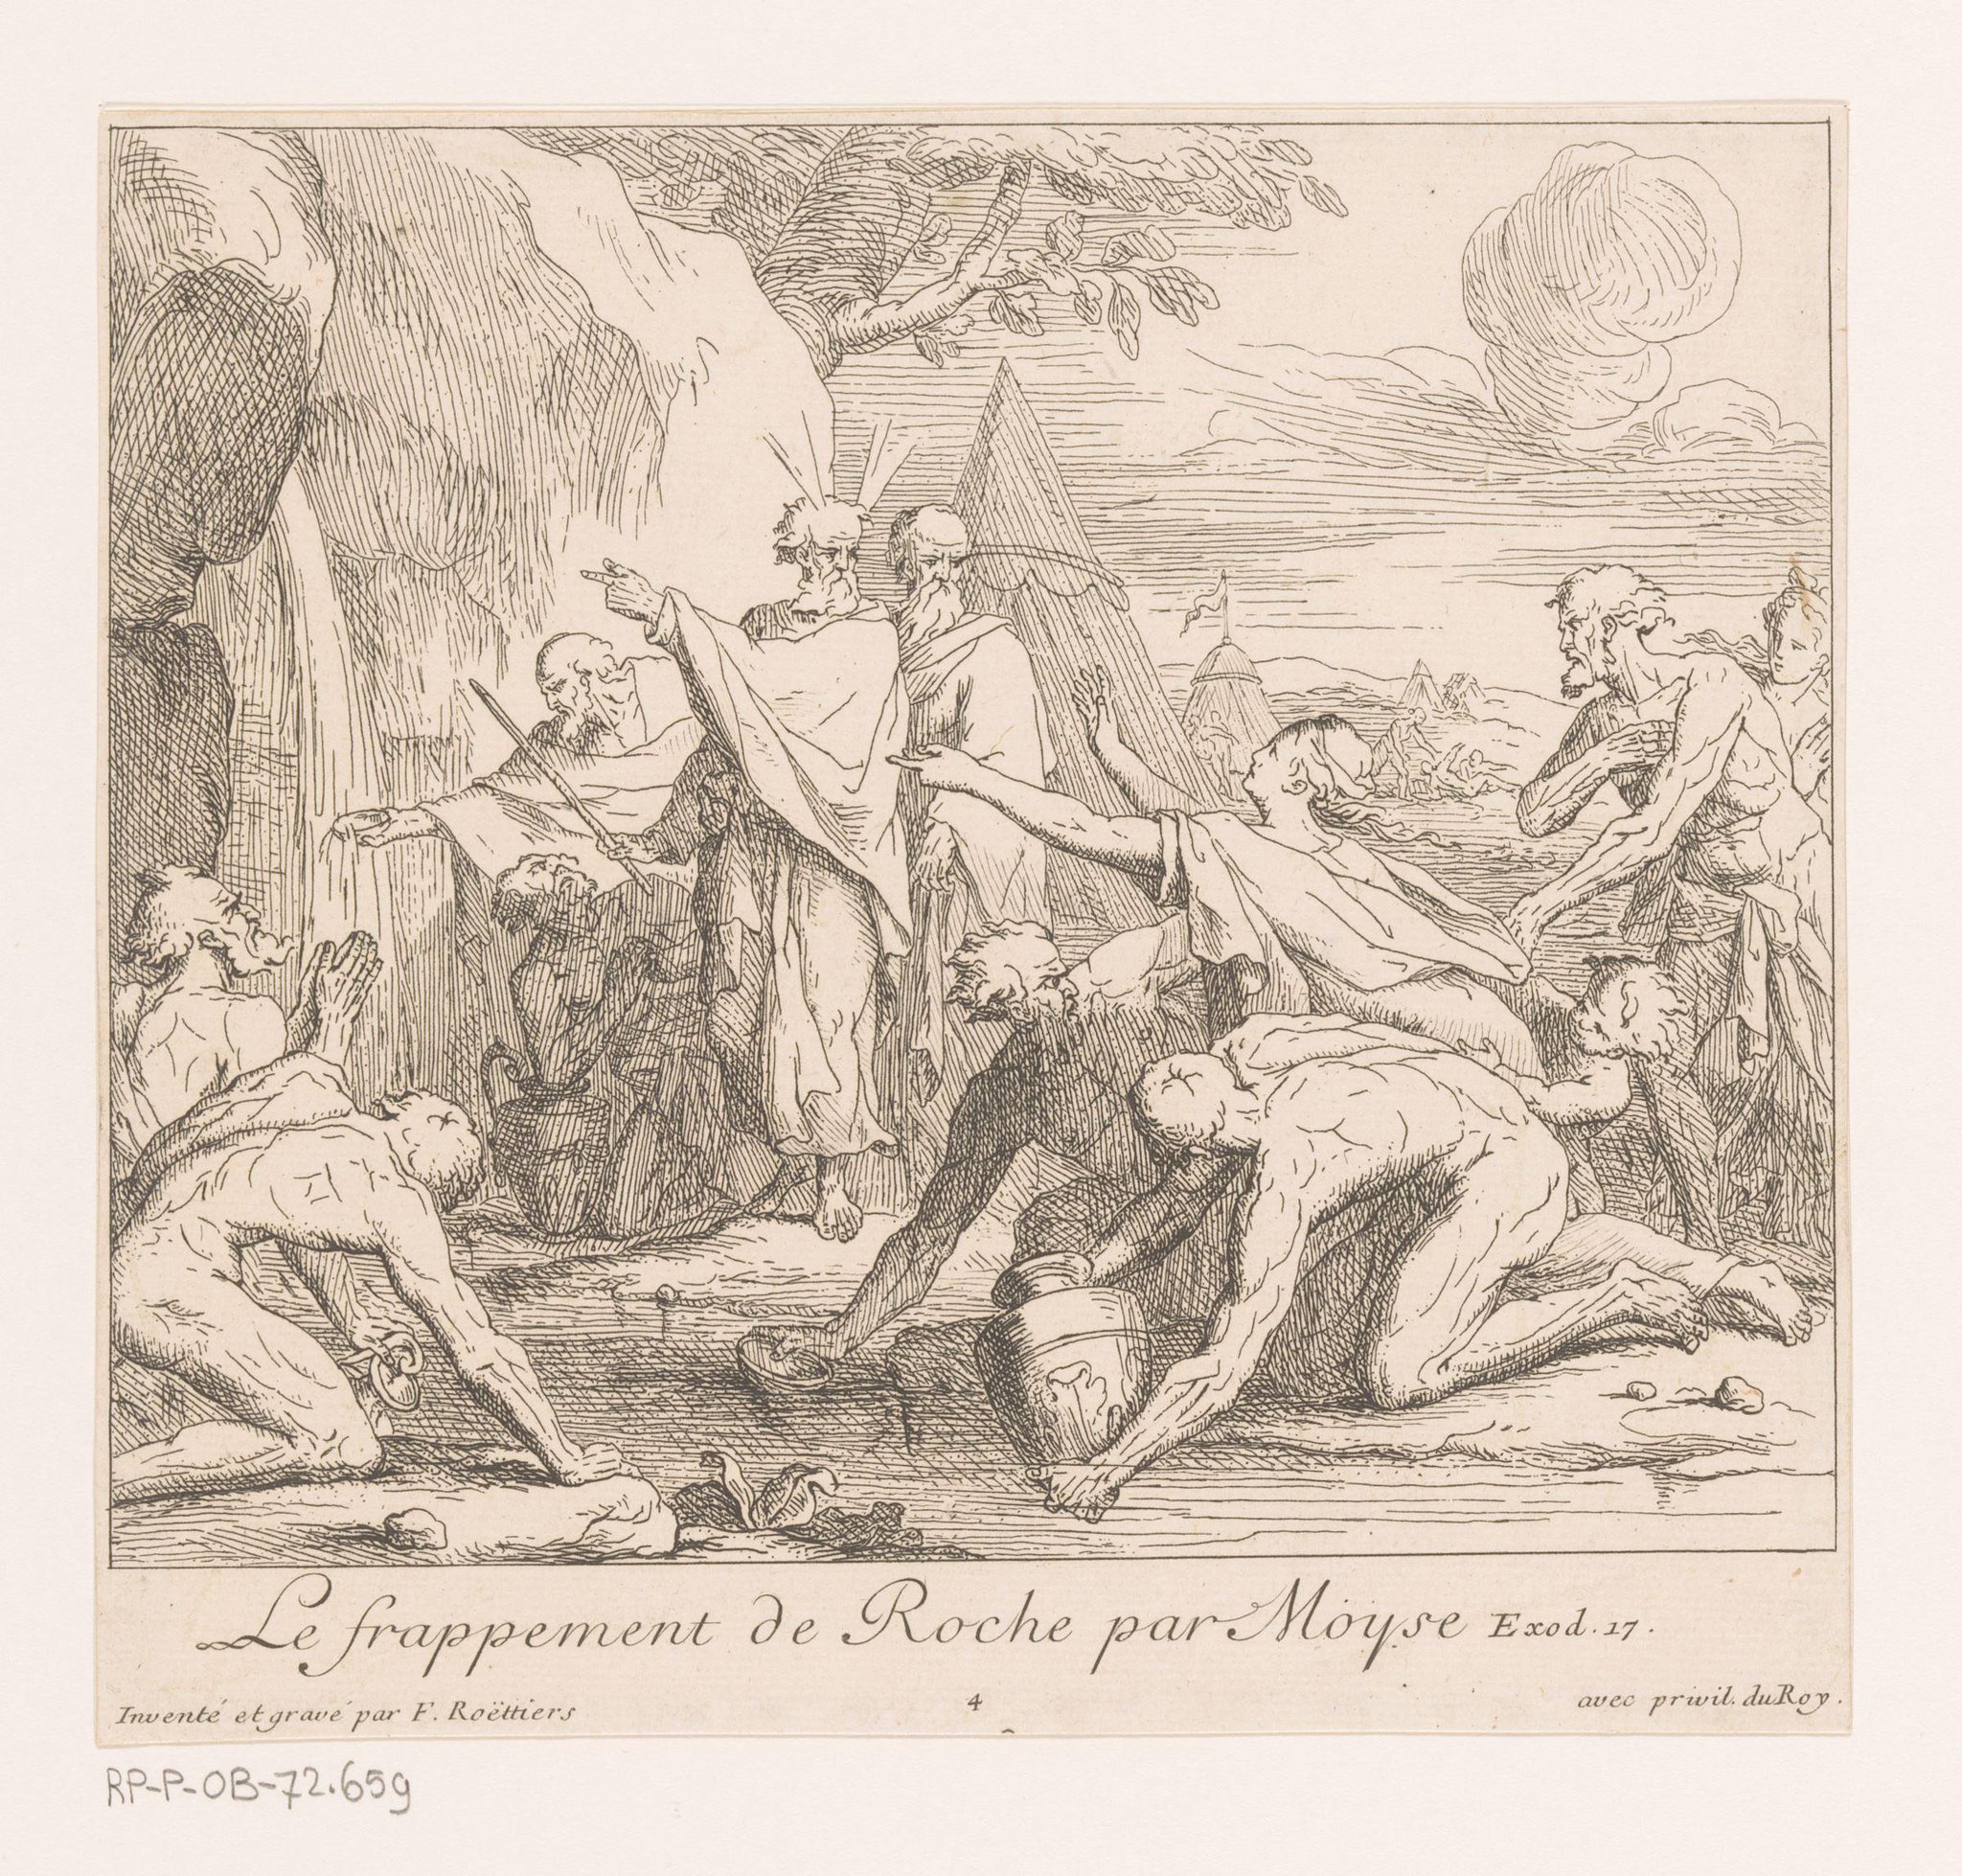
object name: print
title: Le frappement de Roche par Moyse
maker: françois roëttiers (i)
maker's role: print maker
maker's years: 1685-1743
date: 1695-1742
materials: paper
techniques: etching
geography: france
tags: moses striking water from the rock (exodus 17:1-7; numbers 20:2-13)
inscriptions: collector's mark: Lugt 240